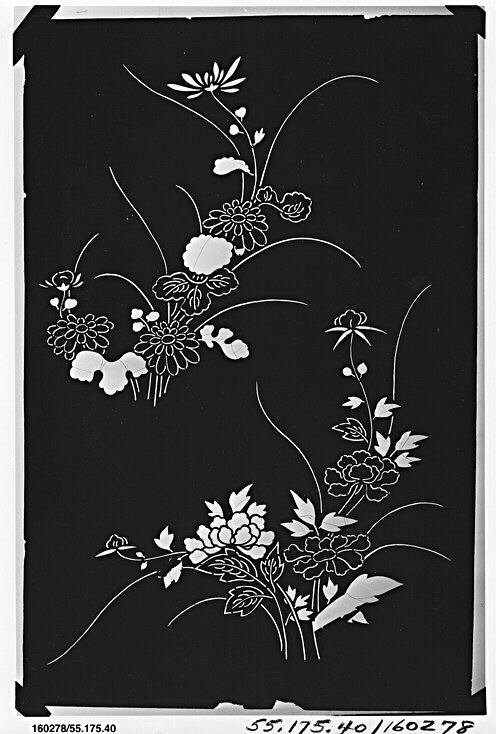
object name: stencil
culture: japanese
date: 1801-1900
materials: paper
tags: flowers